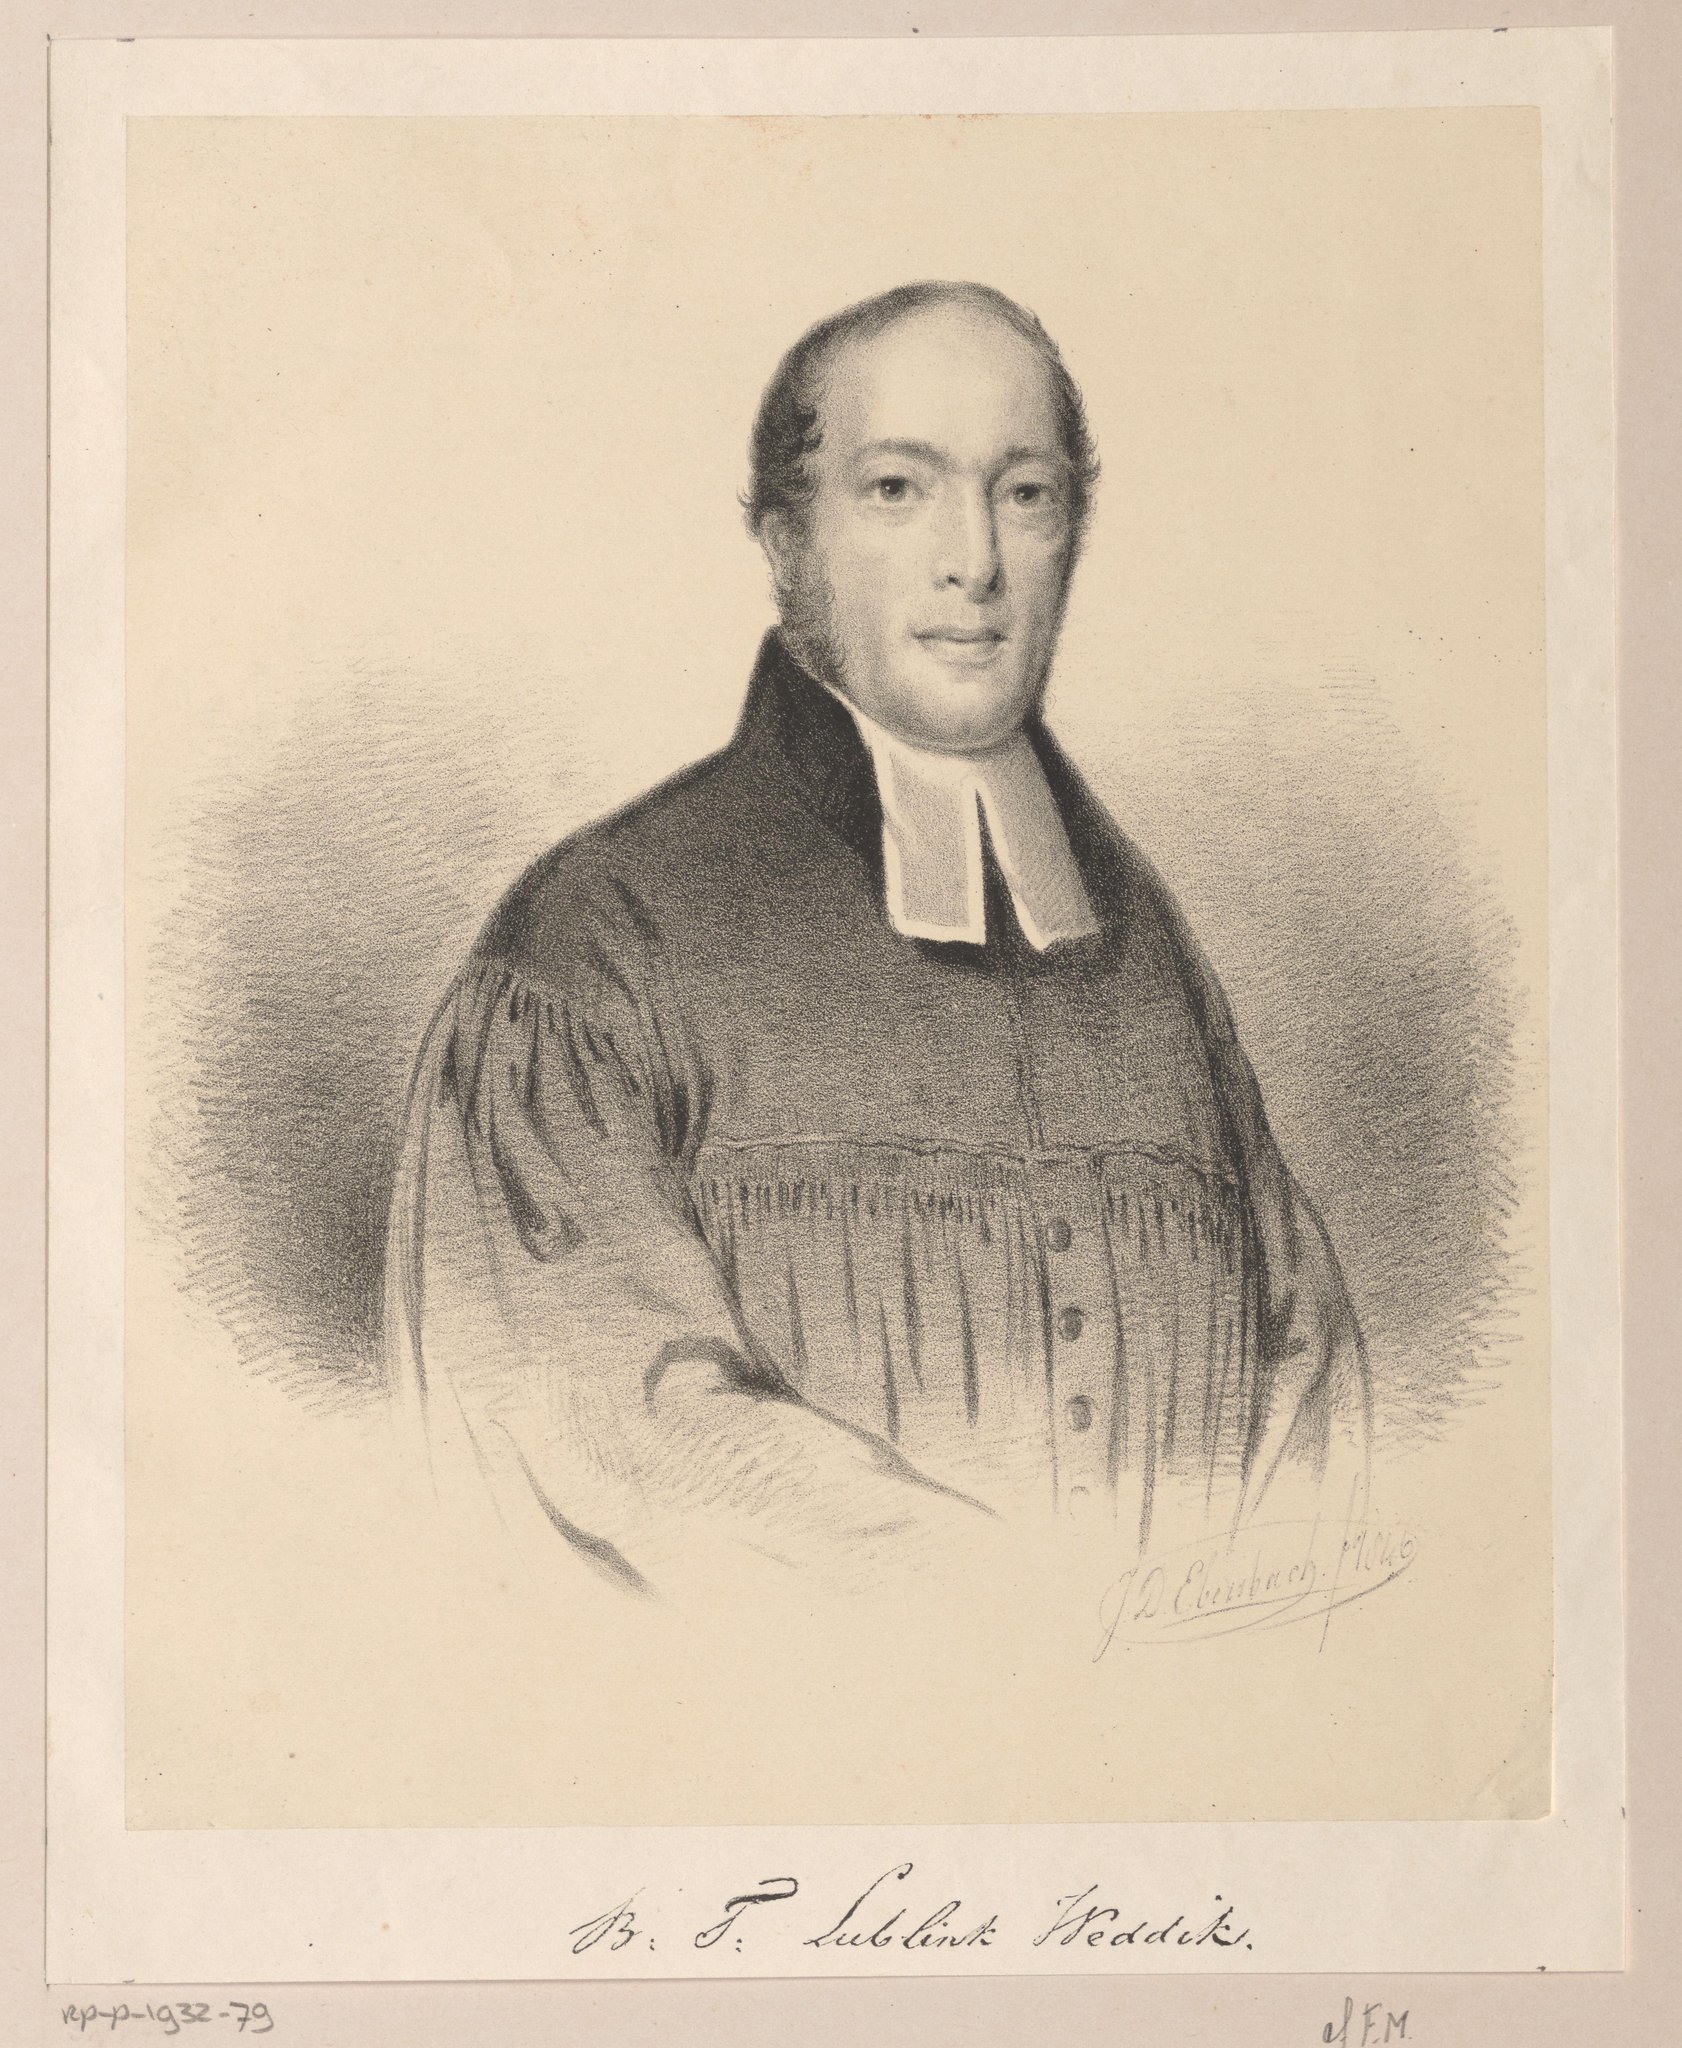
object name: print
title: Portret van Bartholomeus Theodus Lublink Weddik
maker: johan daniel ebersbach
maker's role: print maker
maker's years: 1822-1900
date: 1846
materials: paper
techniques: lithograph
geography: netherlands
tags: utrecht, functionaries and dignitaries (with name) ~ protestant churches, historical persons